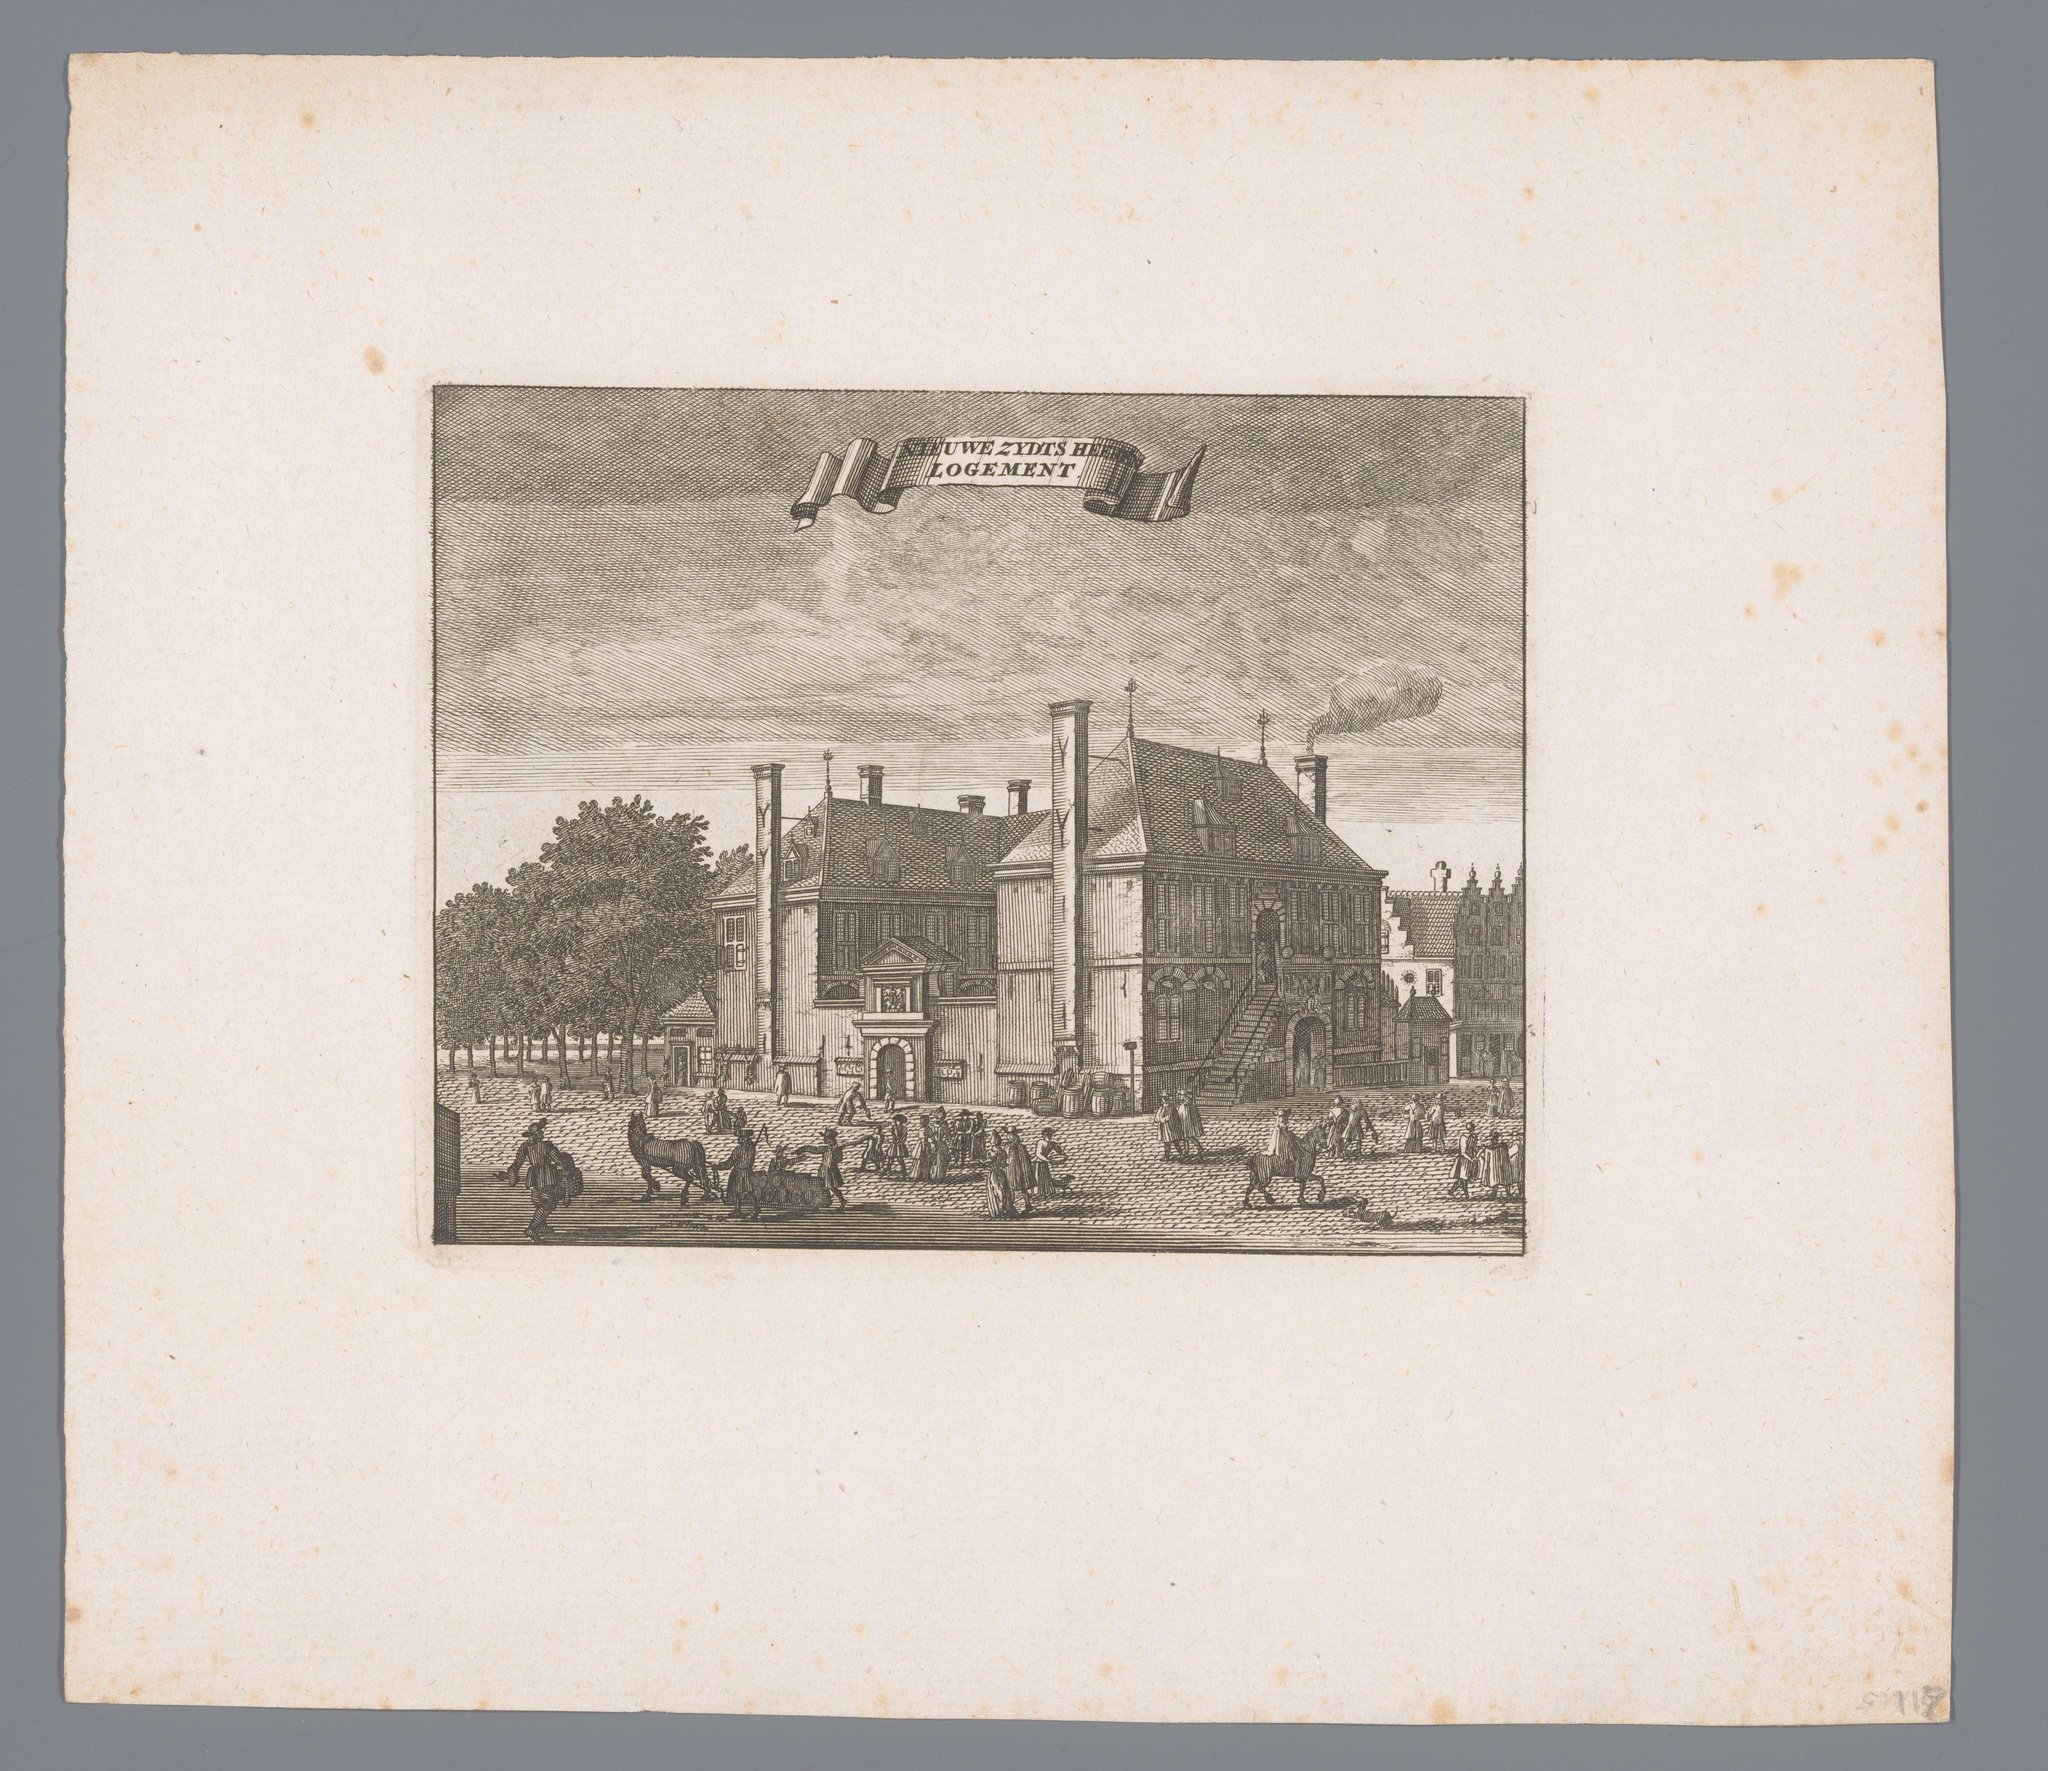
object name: print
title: Nieuwe Zydts Heeren Logement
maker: Anonymous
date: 1693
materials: paper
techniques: etching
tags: animal-drawn sledge (dutch: 'toeslede'), hotel, hostelry, inn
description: Deze prent komt ook voor in: Commelin, Caspar. Beschryvinge van Amsterdam (...). Amsterdam: Abraham Wolfgang et al., 1693, dl. 2, p. 672. Evenals in: Amsterdam: Weduwe Aart Dirksz. Oossaan, 1694. Tevens in: Amsterdam: Andries van Damme et al., 1726. In deze boeken is de prent echter op een bladzijde met tekst gedrukt, met tevens tekst op het verso. Dat is bij dit exemplaar niet het geval. Mogelijk is dit een latere, los uitgegeven afdruk, ook gezien de verschillen in arcering van de grond en de lucht.